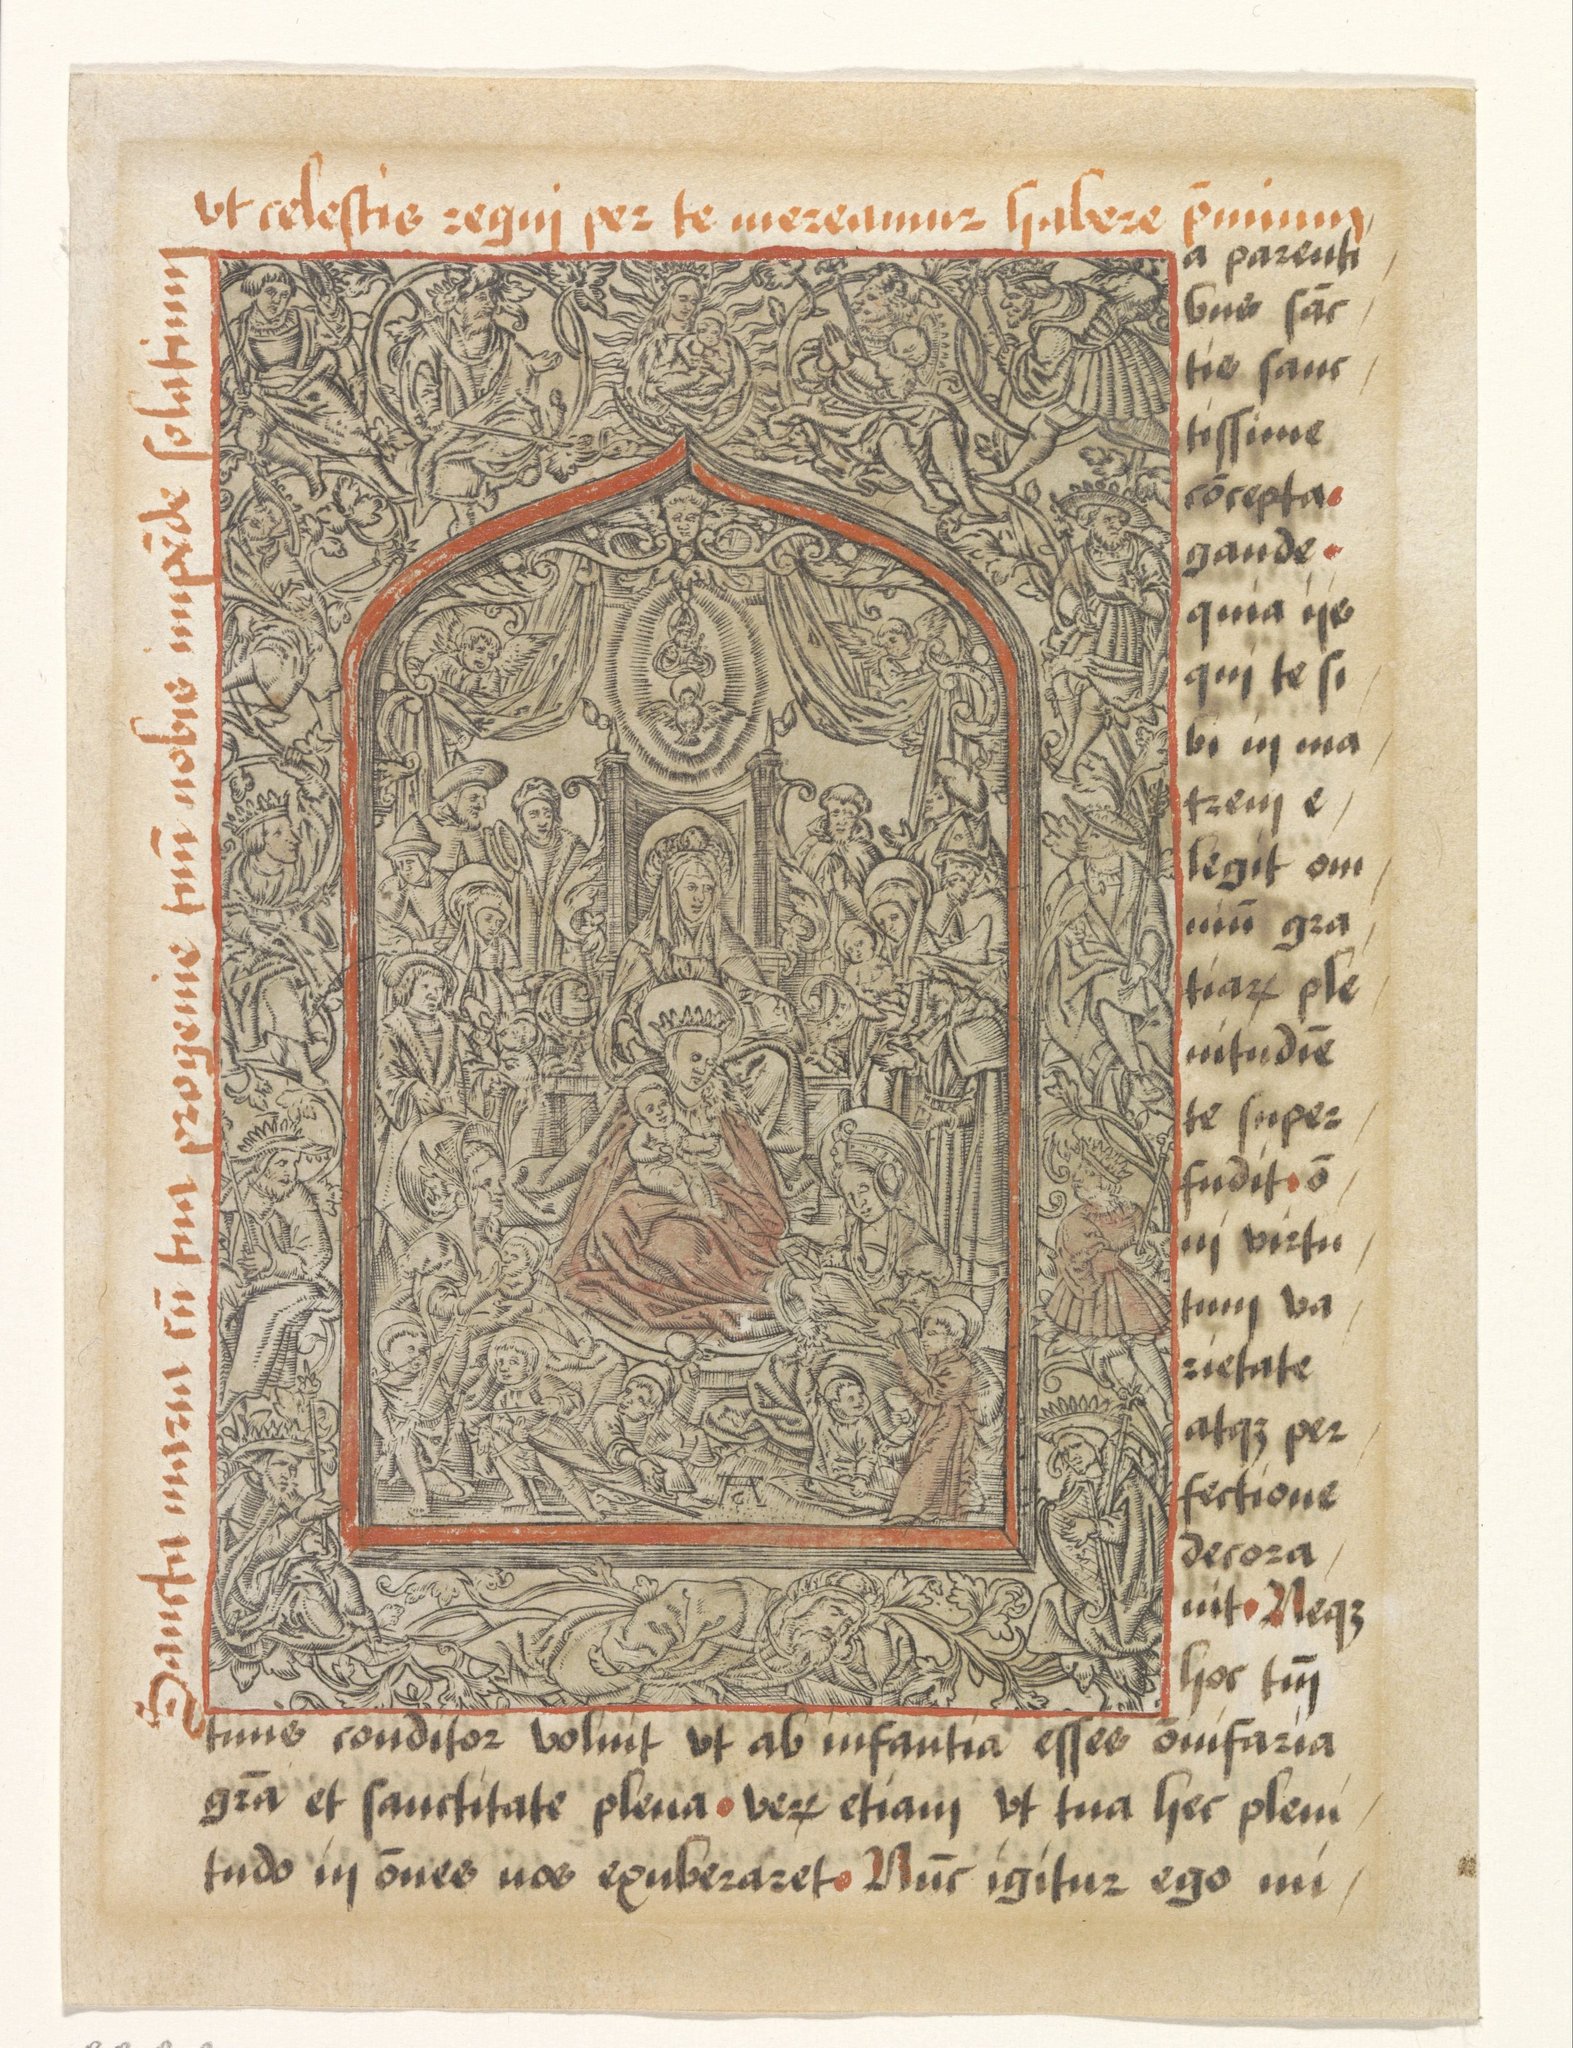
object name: print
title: Heilige Maagschap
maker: allaert claesz.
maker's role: print maker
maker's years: 1508-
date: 1525-1535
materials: paper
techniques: engraving